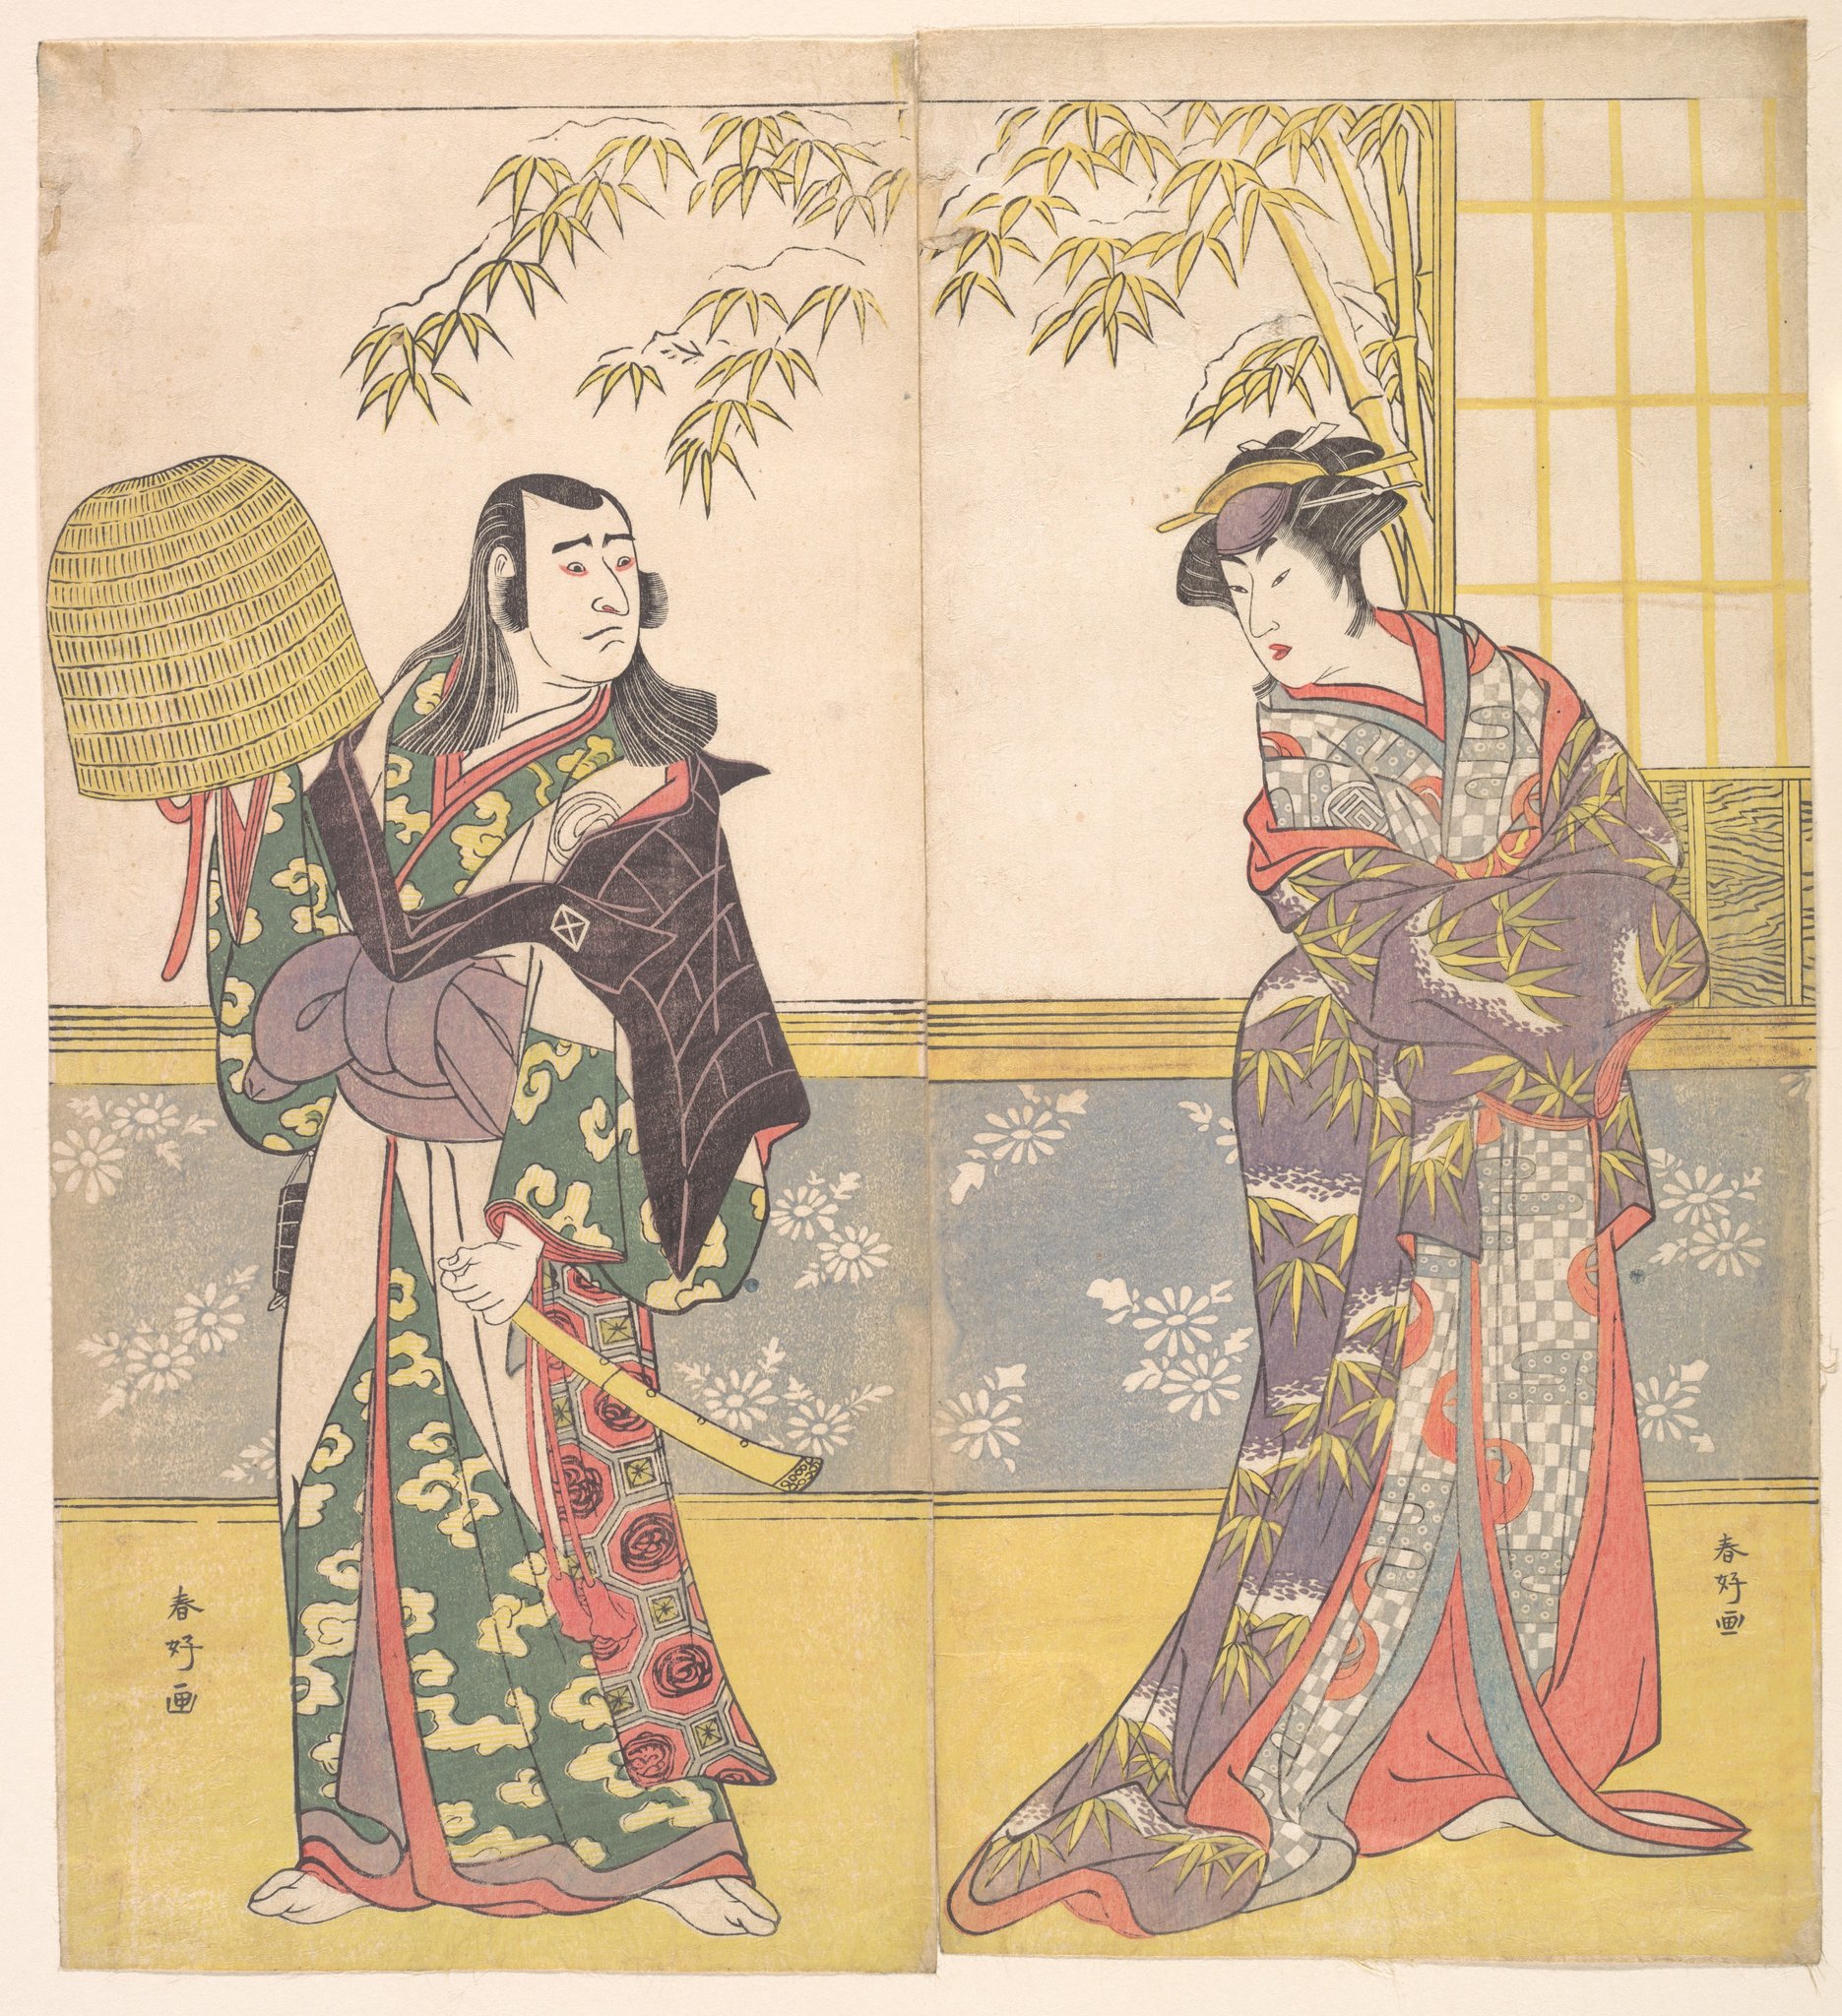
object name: woodblock print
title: Kabuki Actors Sawamura Sōjūrō III and Sanogawa Ichimatsu III in "A Courtesan’s Mirror for the Eastern Provinces" (Keisei Azuma kagami)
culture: japanese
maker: katsukawa shunkō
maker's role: artist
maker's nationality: japanese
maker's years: 1743-1812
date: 1788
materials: ink, paper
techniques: woodblock print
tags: trees,actors